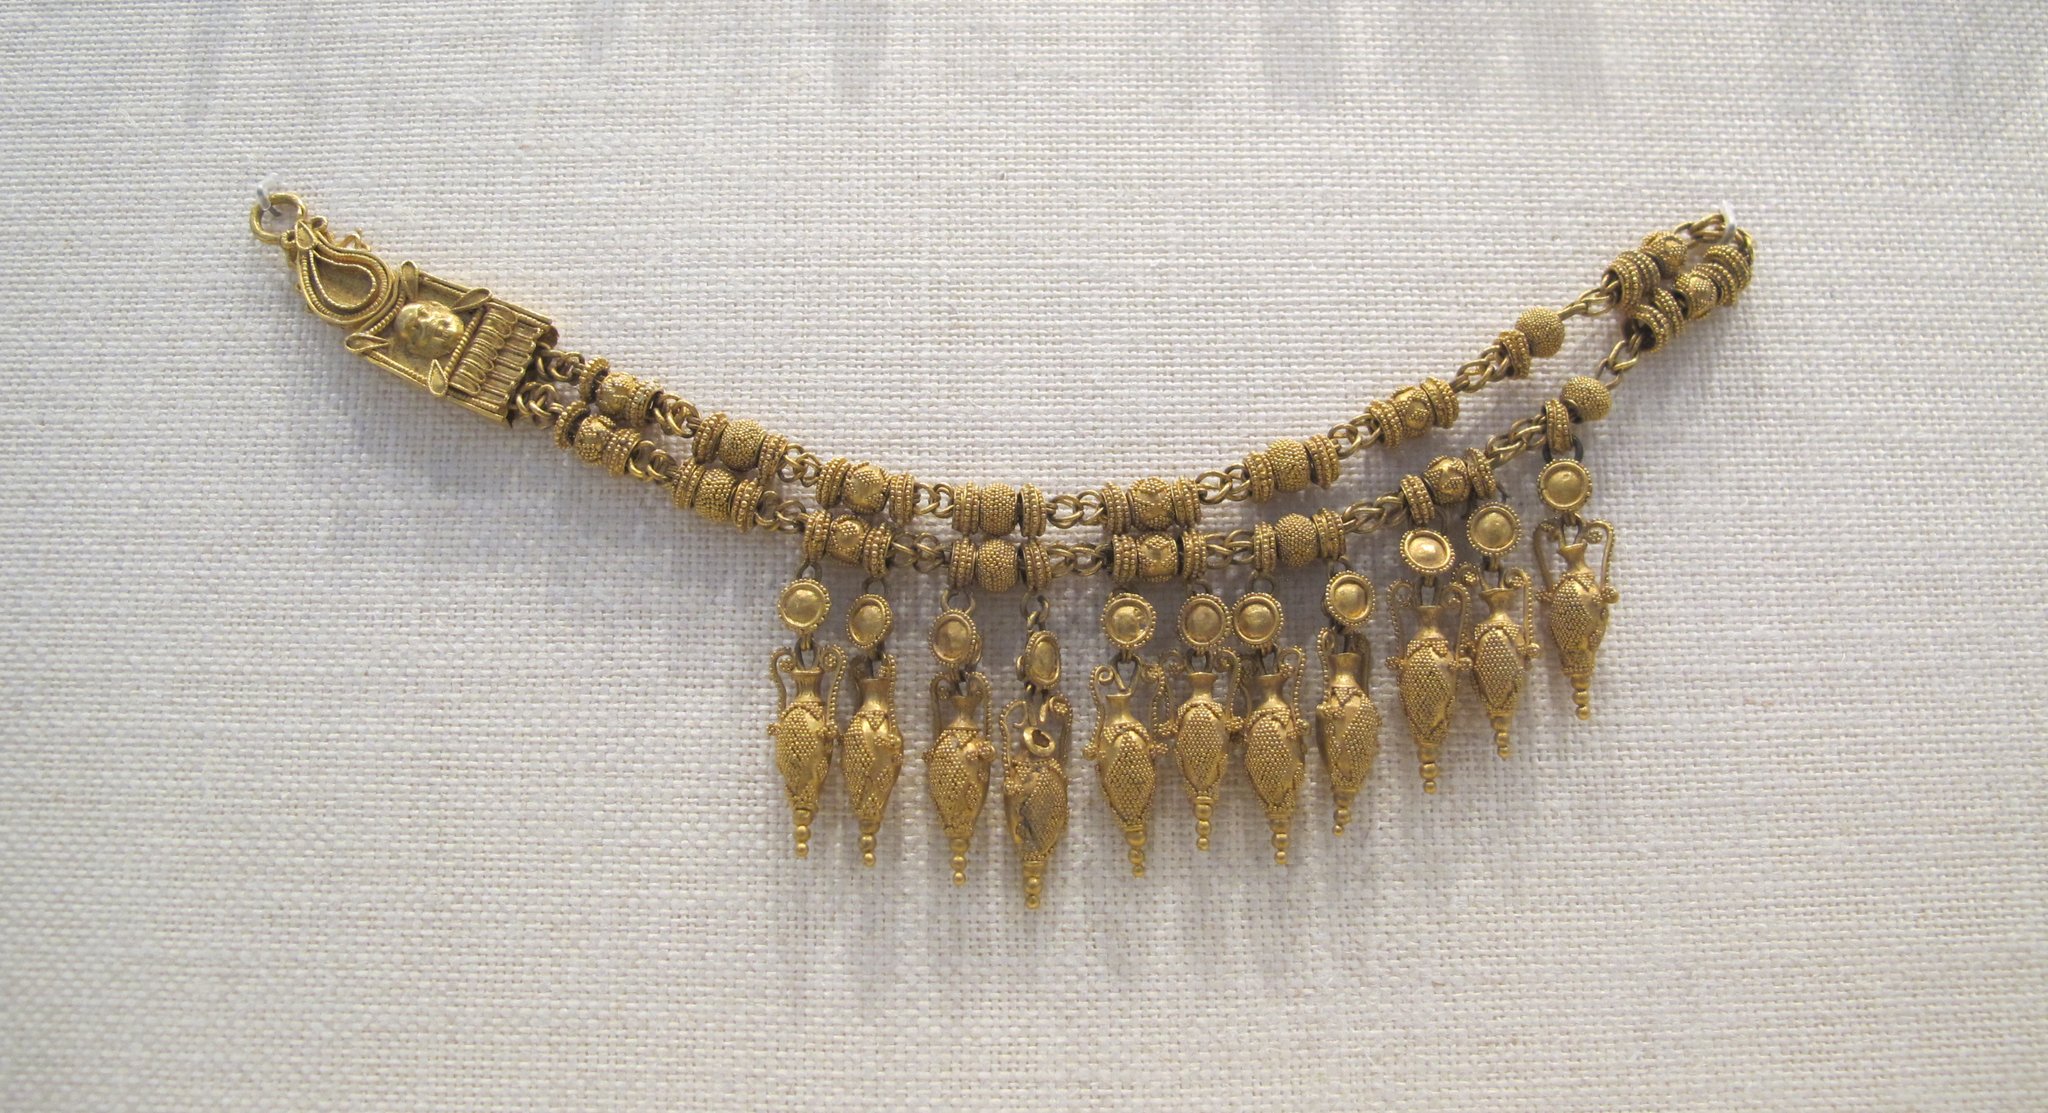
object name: pendant jewelry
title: Gold necklace with pendants of amphora and beads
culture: british or italian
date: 1840-1870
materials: gold